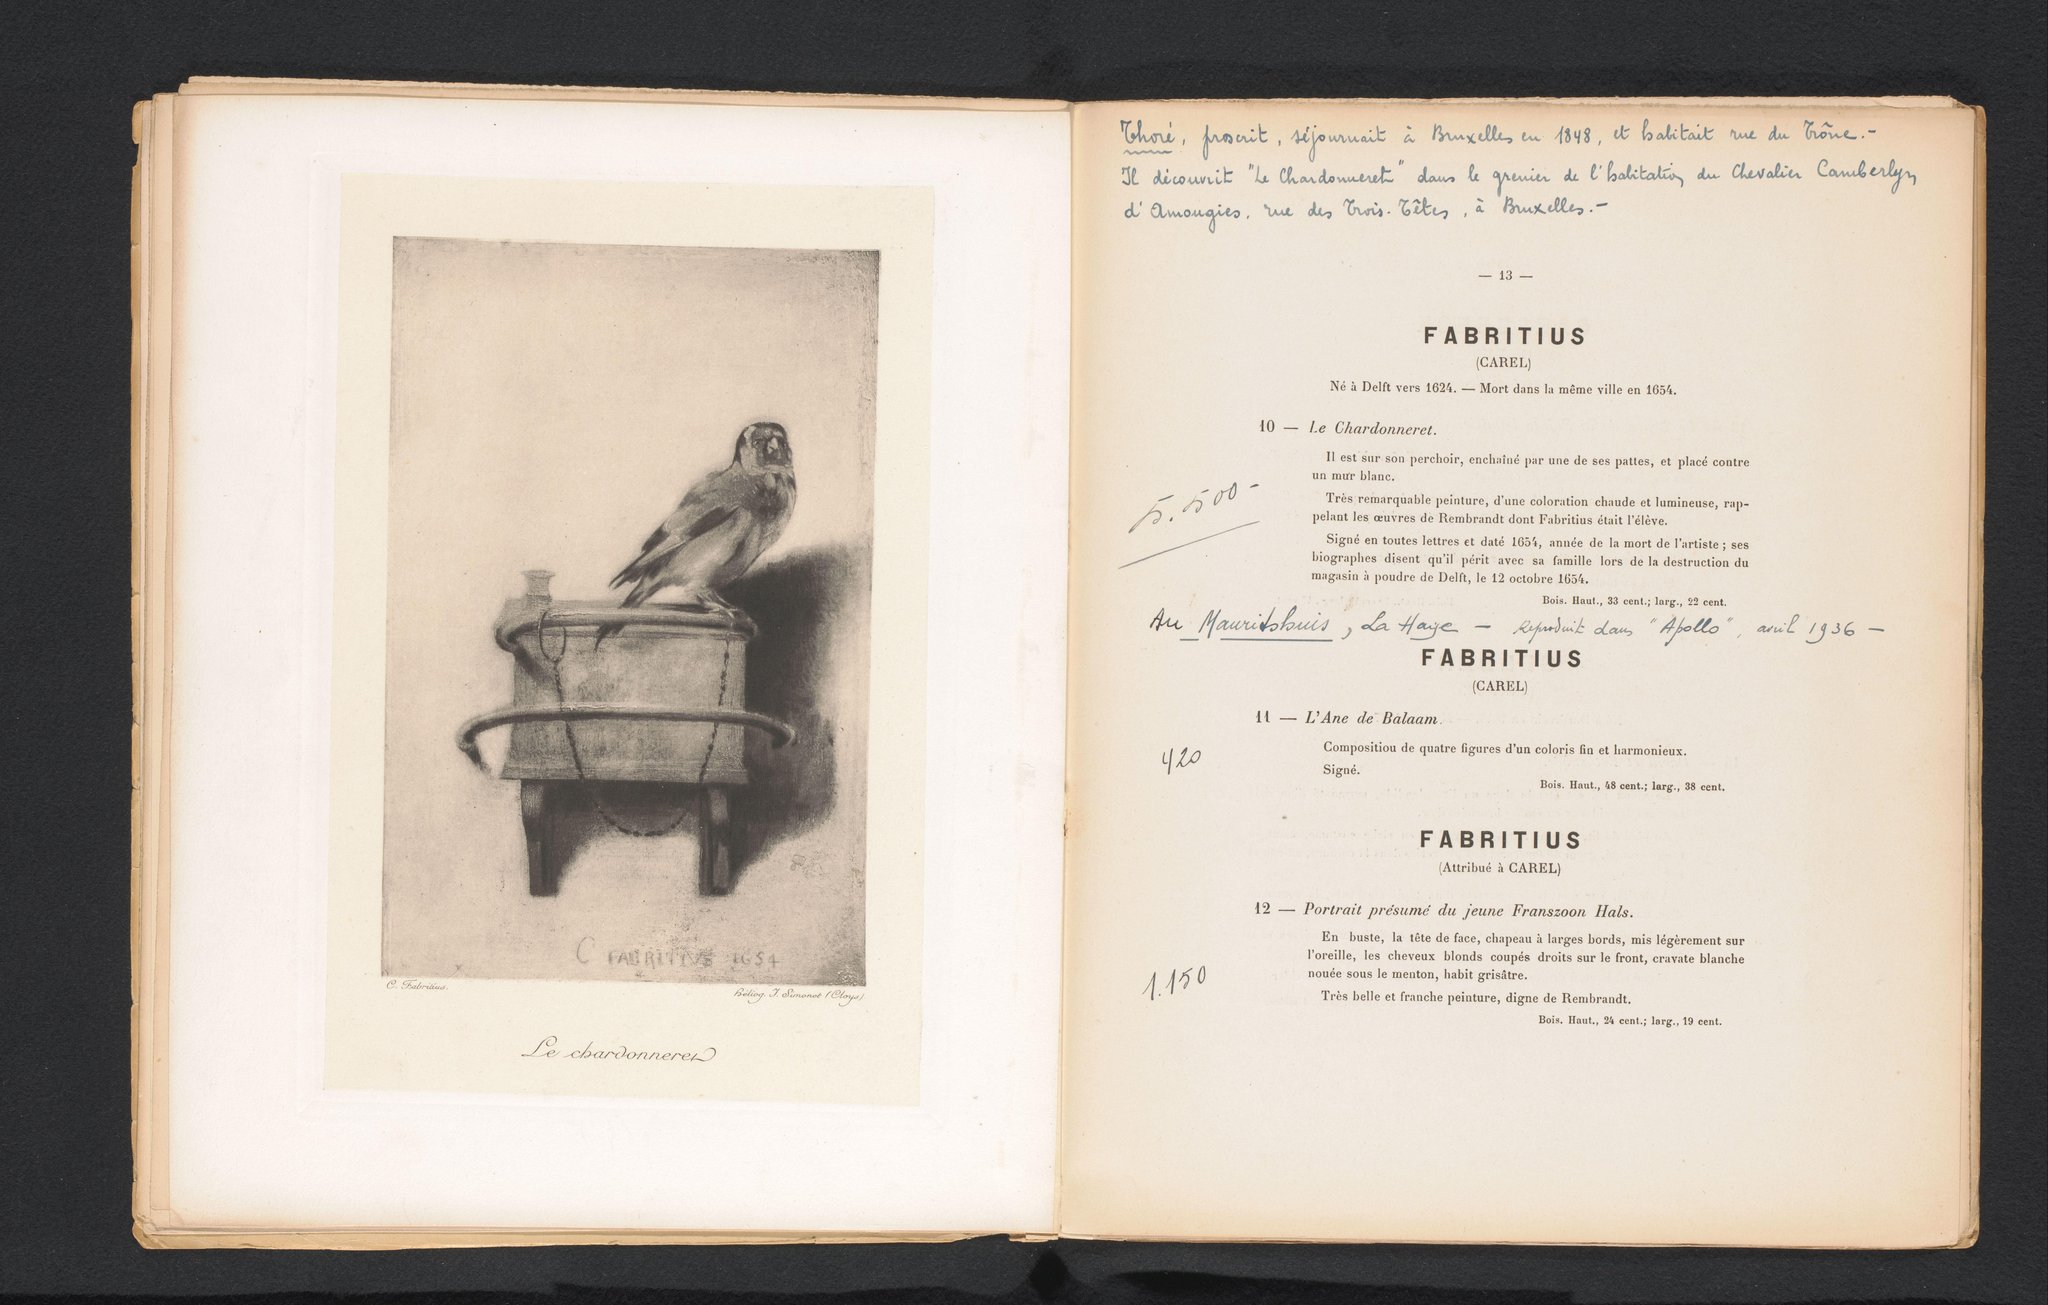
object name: reproduction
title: Reproductie van Het Puttertje van Carel Fabritius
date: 1887-1892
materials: paper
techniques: photoaquatint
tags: song-birds: goldfinch, painting, drawing and the graphic arts